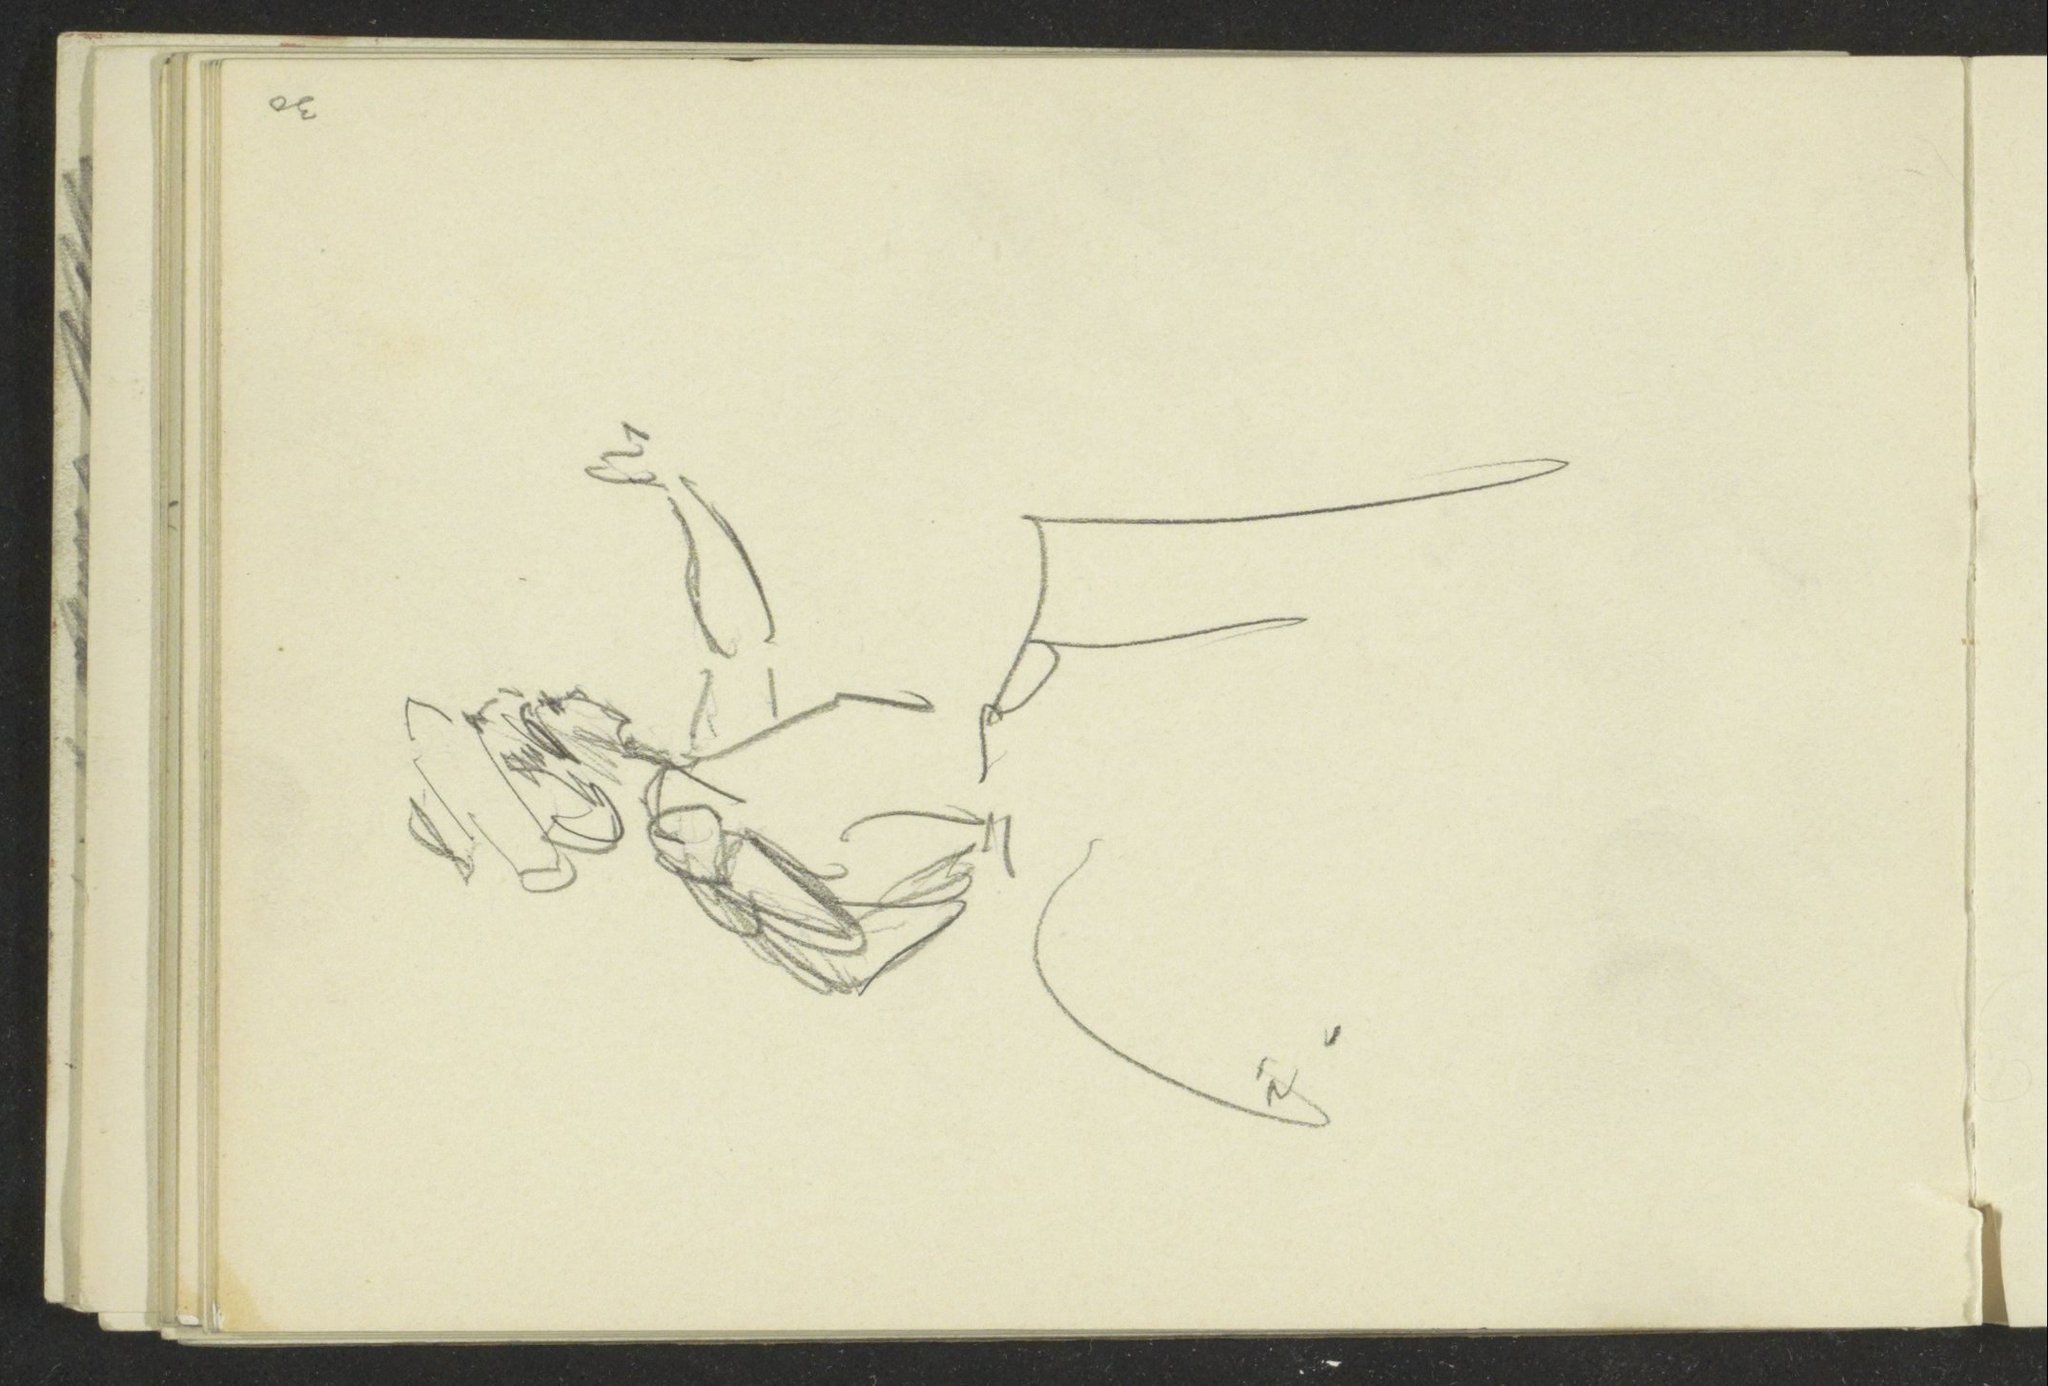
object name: sketchbook leaf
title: Vrouw met uitgestoken linkerarm, in profiel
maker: isaac israels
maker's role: draughtsman, painter, print maker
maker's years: 1865-1934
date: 1875-1934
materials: paper, pencil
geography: the hague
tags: adult woman (+ sideview, profile), arm stretched forward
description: Ze draagt mogelijk een kostuum. Blad 21 verso uit schetsboek LXV met 27 bladen.